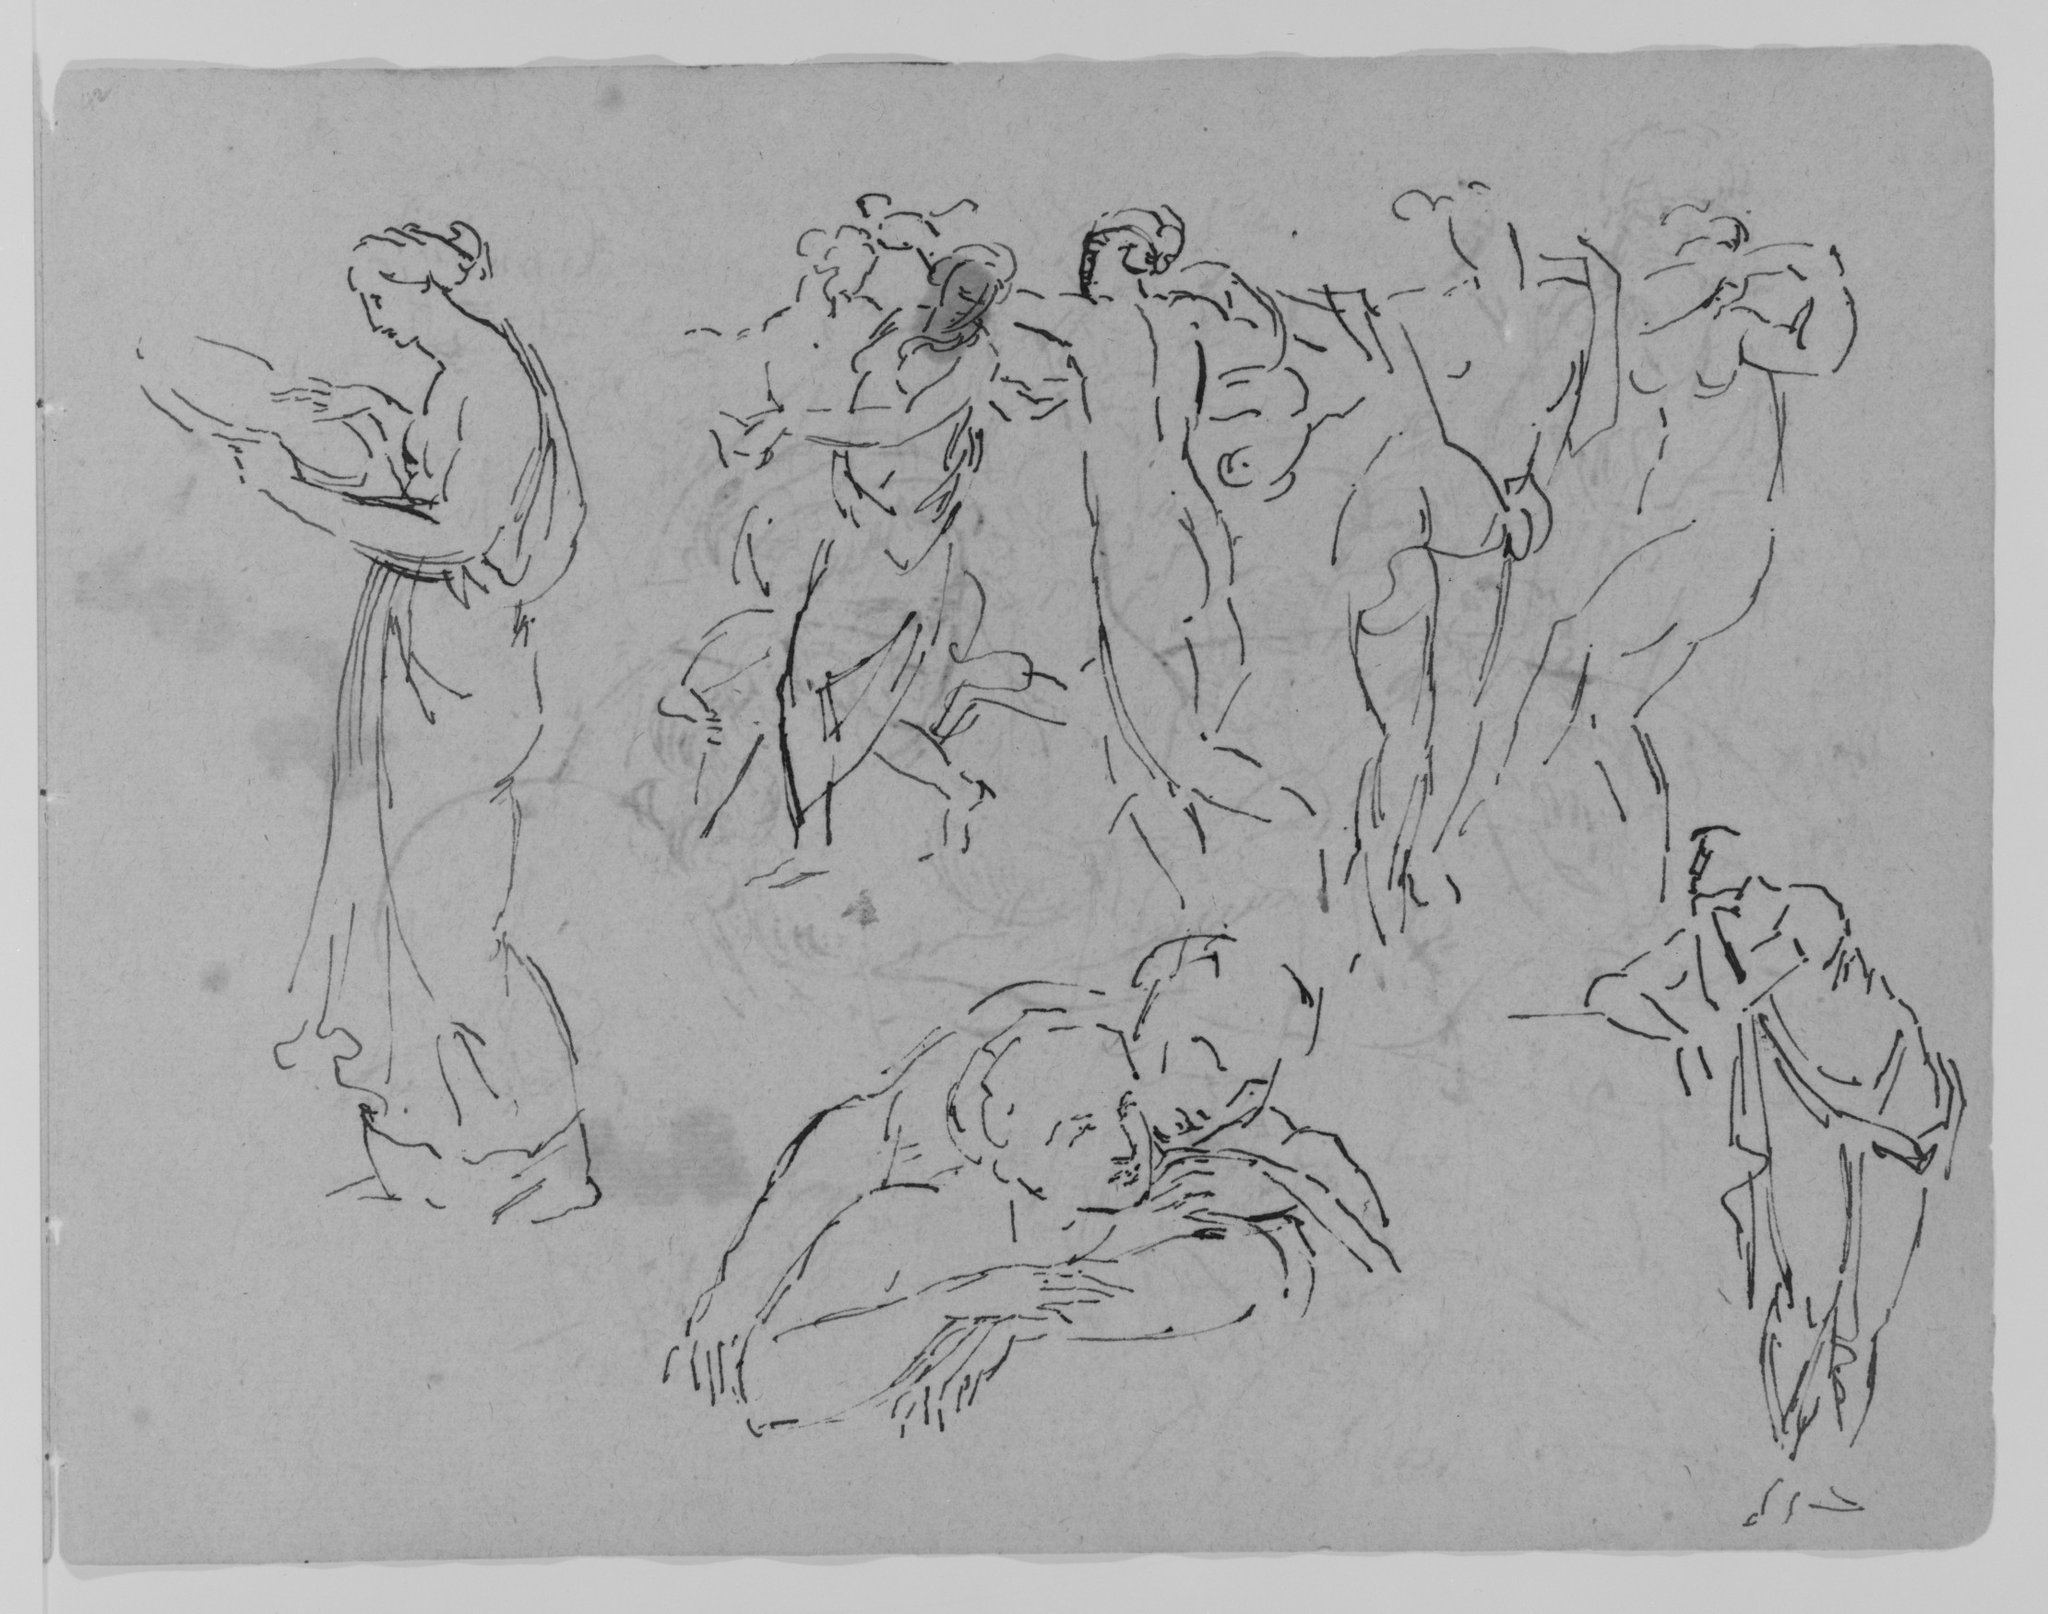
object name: drawing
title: Sketches of Two Women, a Man Fighting a Beast, Two Furniture Fragments (from Sketchbook)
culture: american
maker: thomas sully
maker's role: artist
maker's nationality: american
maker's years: 1783-1872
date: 1810-1820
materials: graphite, ink, paper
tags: men,women